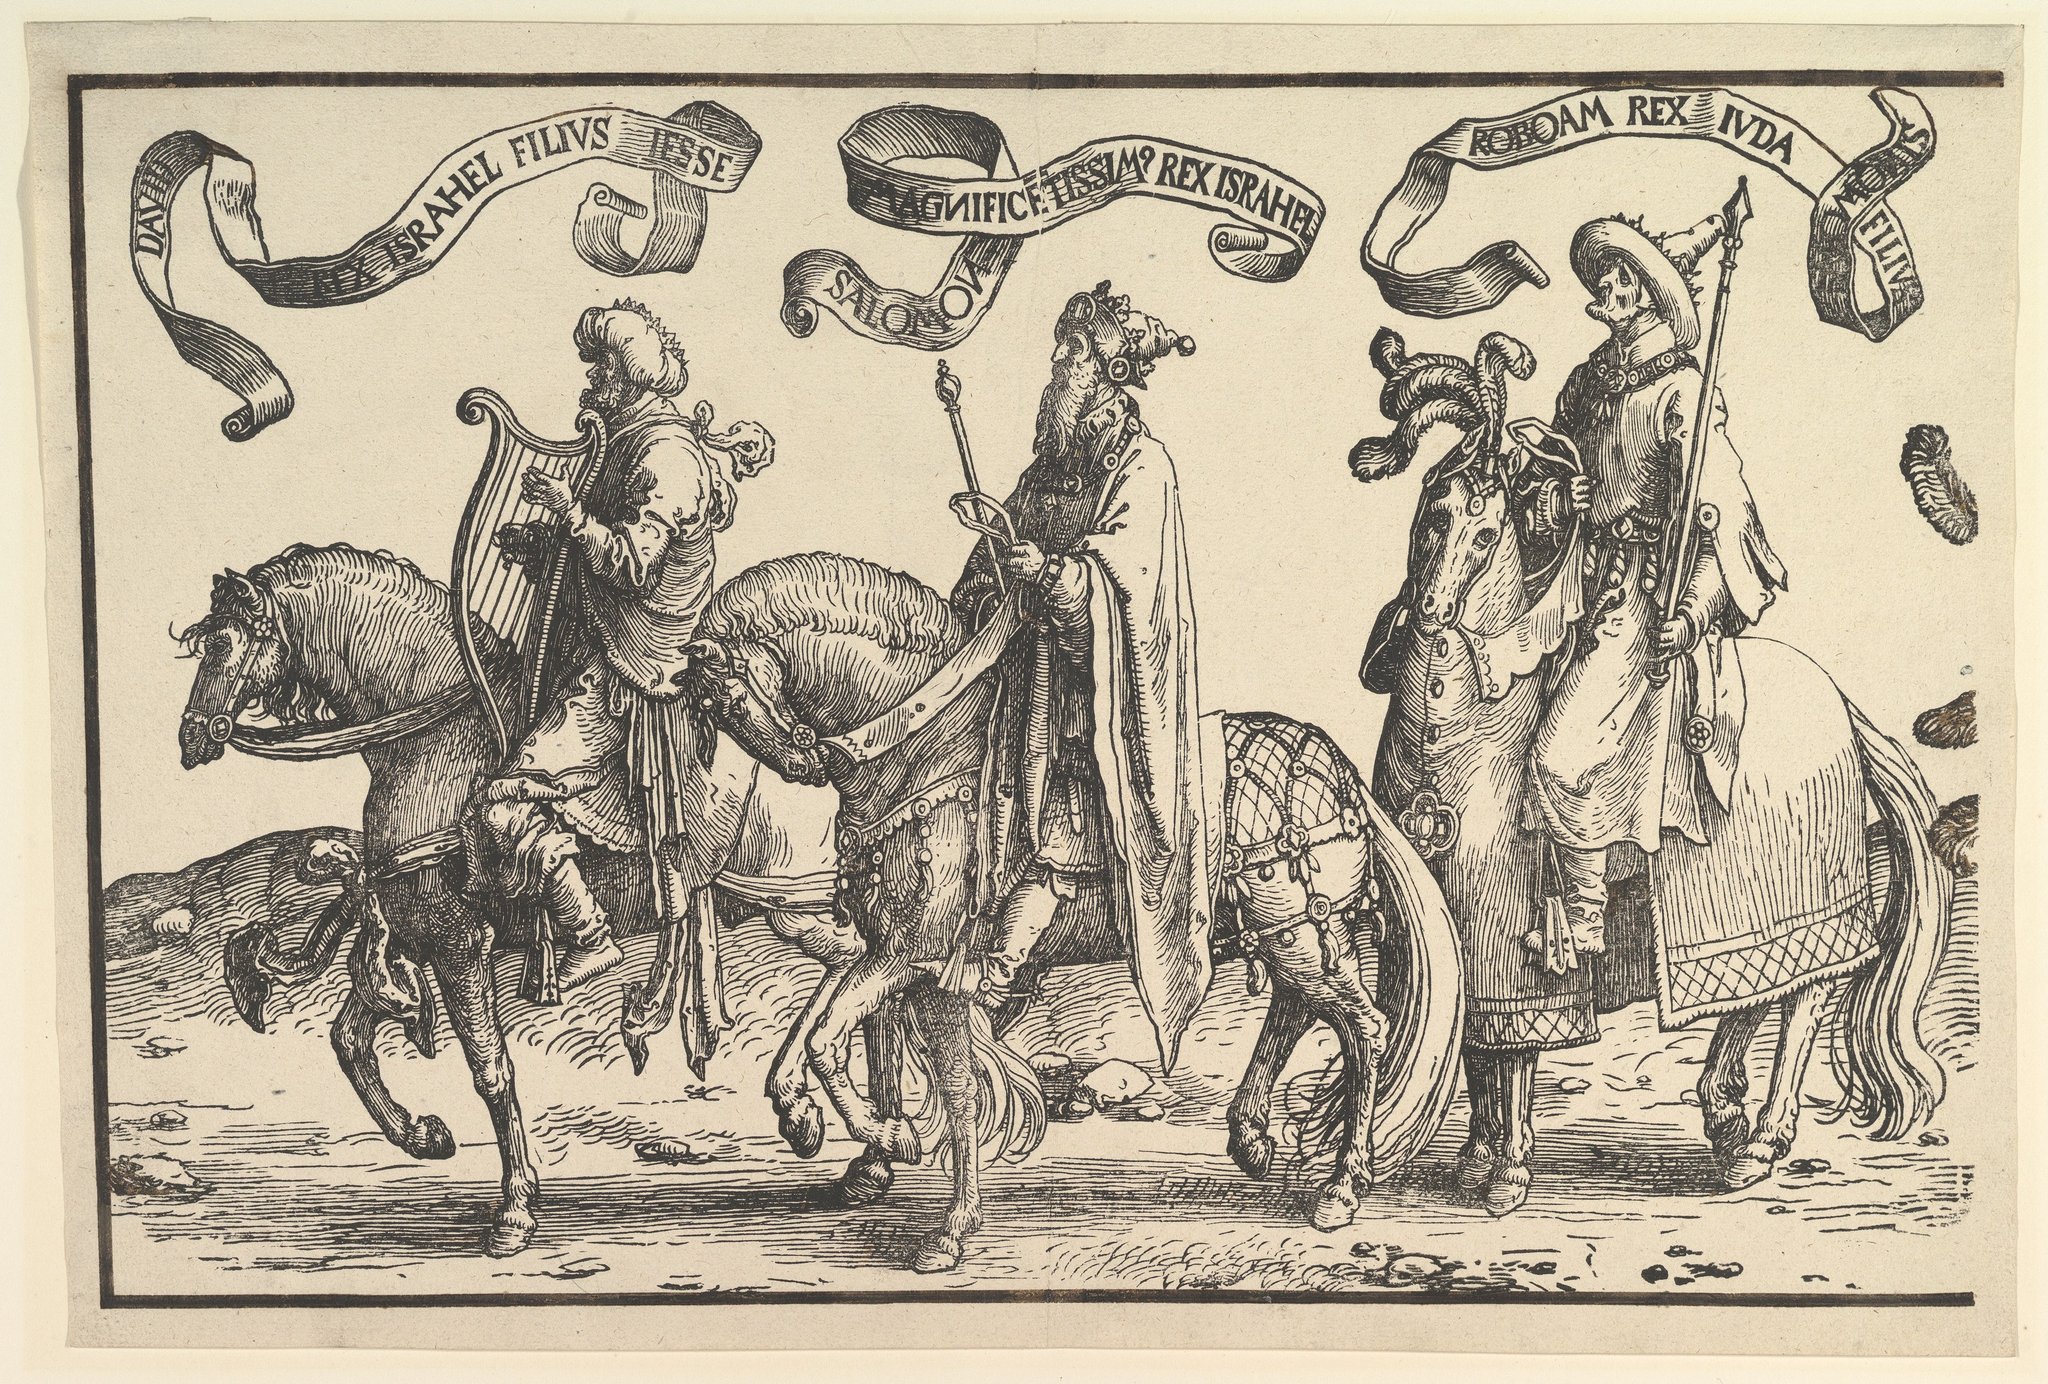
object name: print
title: David, Solomon, Rehoboam, from The Twelve Kings of Israel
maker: lucas van leyden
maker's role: artist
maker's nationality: netherlandish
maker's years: 1494-1533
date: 1520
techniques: woodcut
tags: kings,harps,horses,david